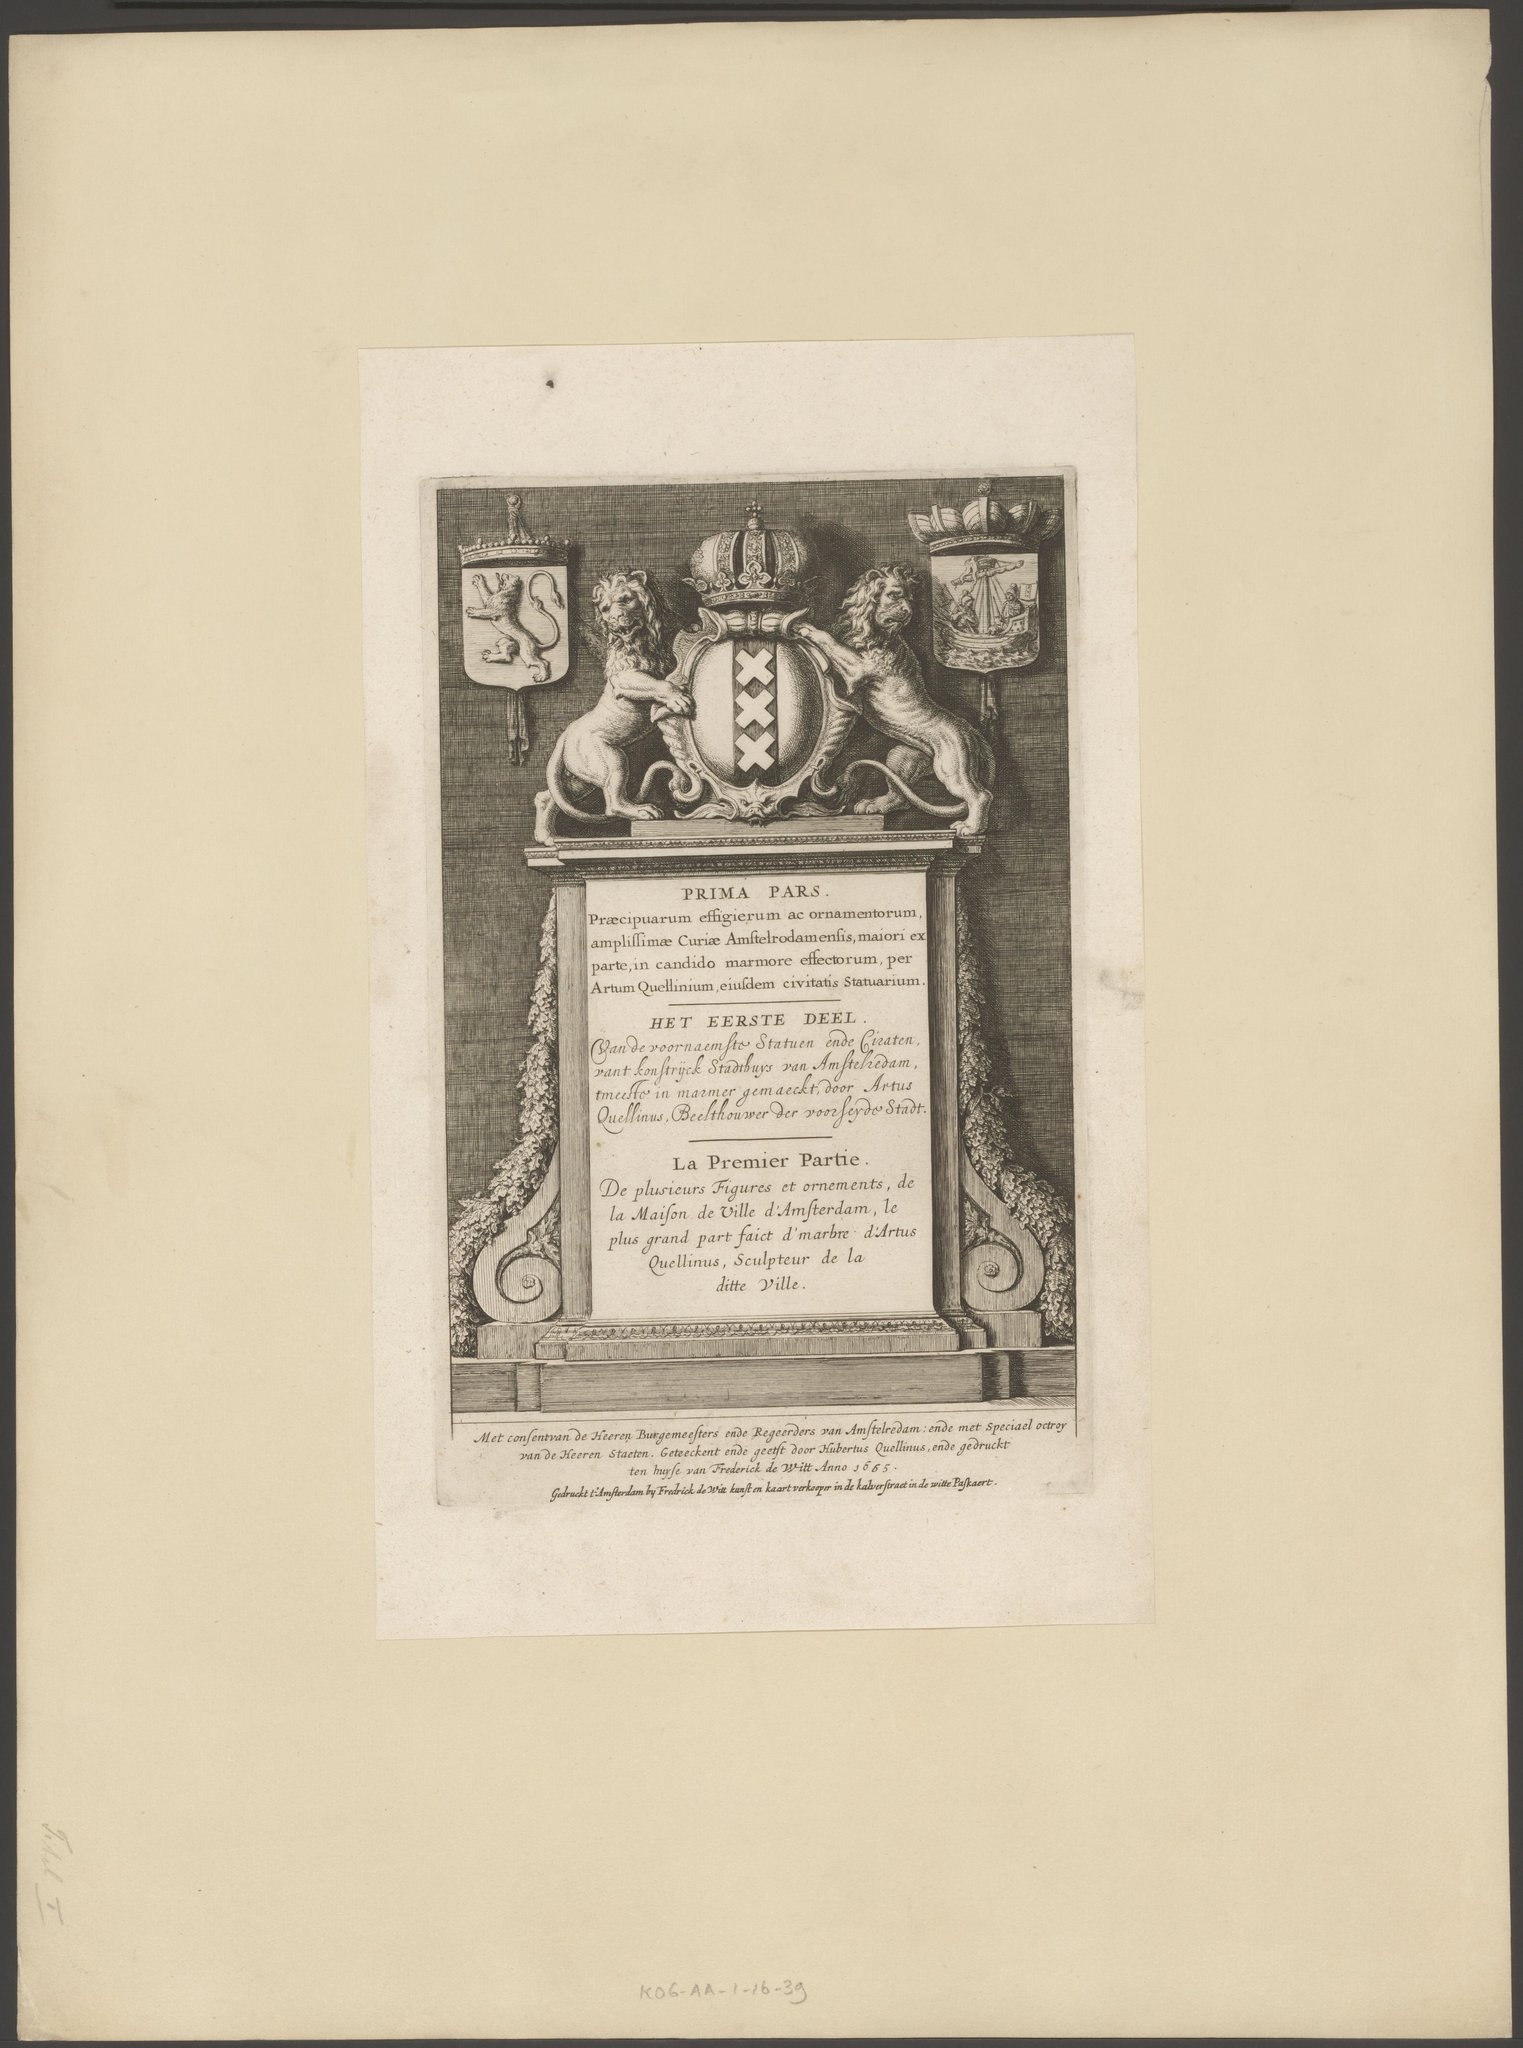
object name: titelblad, titelpagina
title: Sokkel met het wapen van Amsterdam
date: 1665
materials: paper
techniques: engraving, etching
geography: amsterdam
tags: coat of arms (as symbol of the state, etc.) (+ city; municipal), seal (as symbol of the state, etc.) (+ city; municipal), title-page, townhall, coat of arms (as symbol of the state, etc.) (+ province; provincial)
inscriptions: collector's mark: ‘16,39’ Lugt 1641b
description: Prent gebruikt in: Prima pars. Praecipuarum effigierum ac ornamentorum, amplissimae Curiae Amstelrodamensis (…) / Het eerste deel. Van de voornaemste Statuen ende Ciraten, vant konstijck Stadhuys van Amstelredam, tmeeste in marmer gemaeckt, door Artus Quellinus, Beelthouwer der voorseyde Stadt / La Premier Partie. De plusieurs Figures et ornements, de la Maison de Ville d'Amsterdam (…). Amsterdam: Frederik de Wit, 1665. Zie RP-P-AO-22-1-2 voor bijhorend register. Zie RP-P-AO-22-1A, RP-P-AO-22-1B, RP-P-AO-22-1C, RP-P-AO-22-1D-1, RP-P-AO-22-1D-2, RP-P-AO-22-1E, RP-P-AO-22-1F, RP-P-AO-22-1G, RP-P-AO-22-1H, RP-P-AO-22-1I, RP-P-AO-22-1K-1, RP-P-AO-22-1K-2, RP-P-AO-22-1K-3, RP-P-AO-22-1K-4, RP-P-AO-22-1K-5, RP-P-AO-22-1L-1, RP-P-AO-22-1L-2, RP-P-AO-22-1M-1, RP-P-AO-22-1N-1, RP-P-AO-22-1N-2, RP-P-AO-22-1N-3, RP-P-AO-22-1N-4, RP-P-AO-22-1N-5, RP-P-AO-22-1O-1, RP-P-AO-22-1O-2, RP-P-AO-22-1O-3, RP-P-AO-22-1O-4, RP-P-AO-22-1P-1, RP-P-AO-22-1P-2, RP-P-AO-22-1P-3, RP-P-AO-22-1P-4, RP-P-AO-22-1Q-1, RP-P-AO-22-1Q-2, RP-P-AO-22-1Q-3, RP-P-AO-22-1Q-4, RP-P-AO-22-1R-1, RP-P-AO-22-1R-2, RP-P-AO-22-1R-3, RP-P-AO-22-1R-4, RP-P-AO-22-1R-5, RP-P-AO-22-1S-1, RP-P-AO-22-1S-2, RP-P-AO-22-1S-3, RP-P-AO-22-1S-4, RP-P-AO-22-1S-5, RP-P-AO-22-1T-1 en RP-P-AO-22-1T-2 voor andere prenten uit deze publicatie. Eerdere staat van prent ook gebruikt in: Prima pars. Praecipuarum effigierum ac ornamentorum, amplissimae Curiae Amstelrodamensis (…) / Het eerste deel. Van de voornaemste Statuen ende Ciraten, vant konstijck Stadhuys van Amstelredam, tmeeste in marmer gemaeckt, door Artus Quellinus, Beelthouwer der voorseyde Stadt / La Premier Partie. De plusieurs Figures et ornements, de la Maison de Ville d'Amsterdam (…). Amsterdam: Artus Quellinus (I), 1655. Zie RP-P-AO-22-2-1 voor titelpagina van tweede deel.